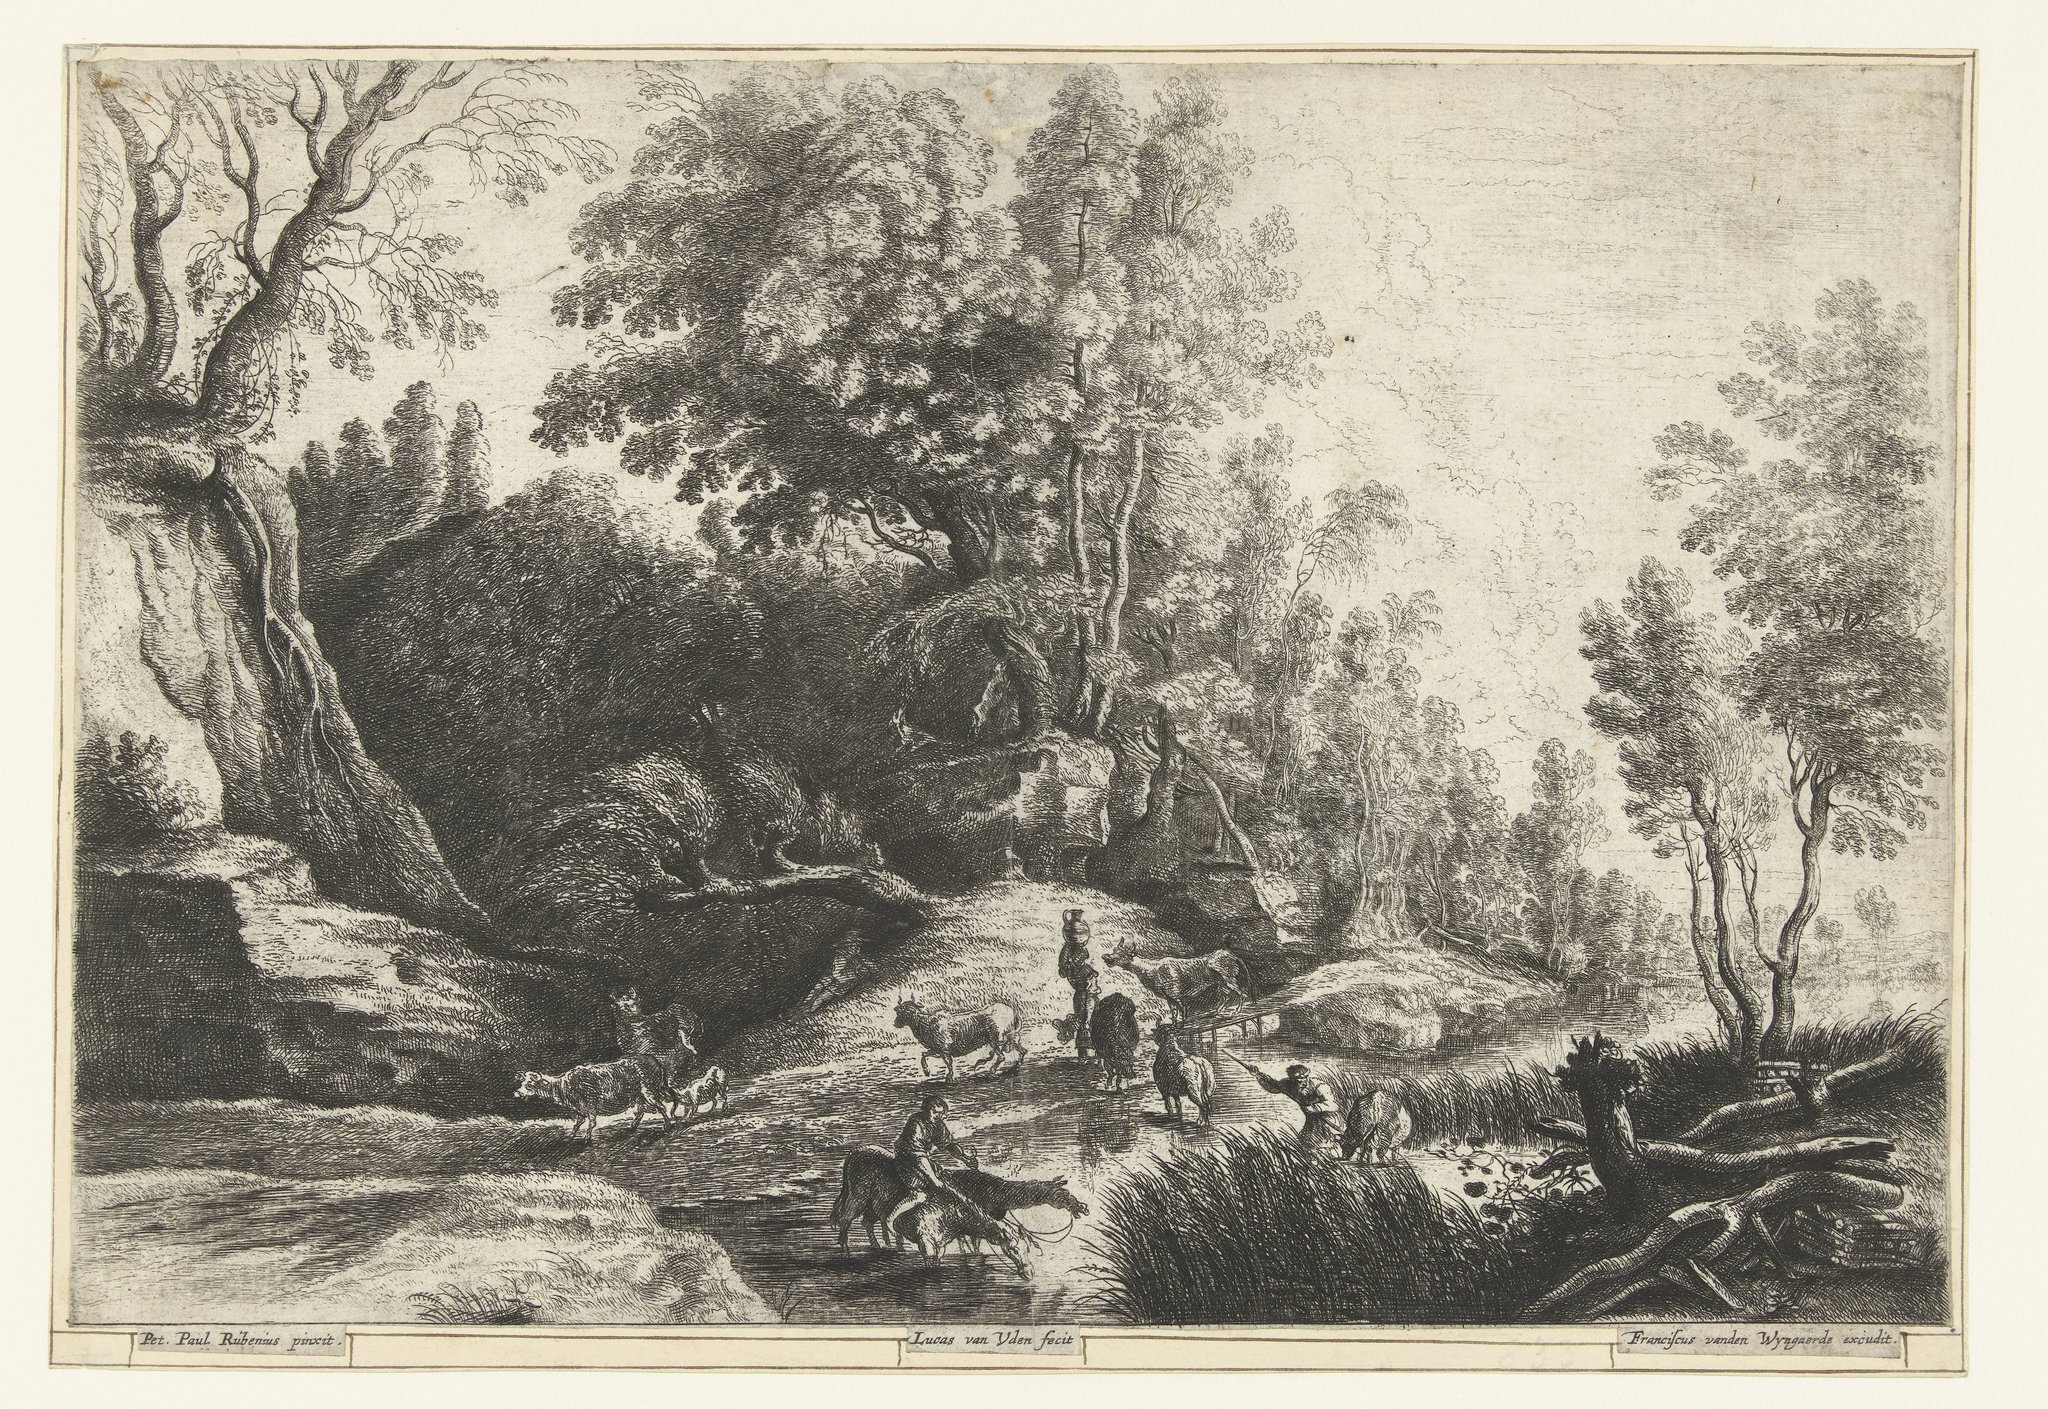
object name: print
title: Paarden en koeien bij een drinkplaats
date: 1615-1673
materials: paper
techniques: engraving, etching, pen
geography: low countries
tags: herding, herdsman, herdswoman, shepherd, shepherdess, cowherd, etc., fringe, edge of the wood, watering-place, spa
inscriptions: collector's mark: Lugt 2228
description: Naar een schilderij van Rubens uit 1615-1622, nu in The National Gallery, Londen.